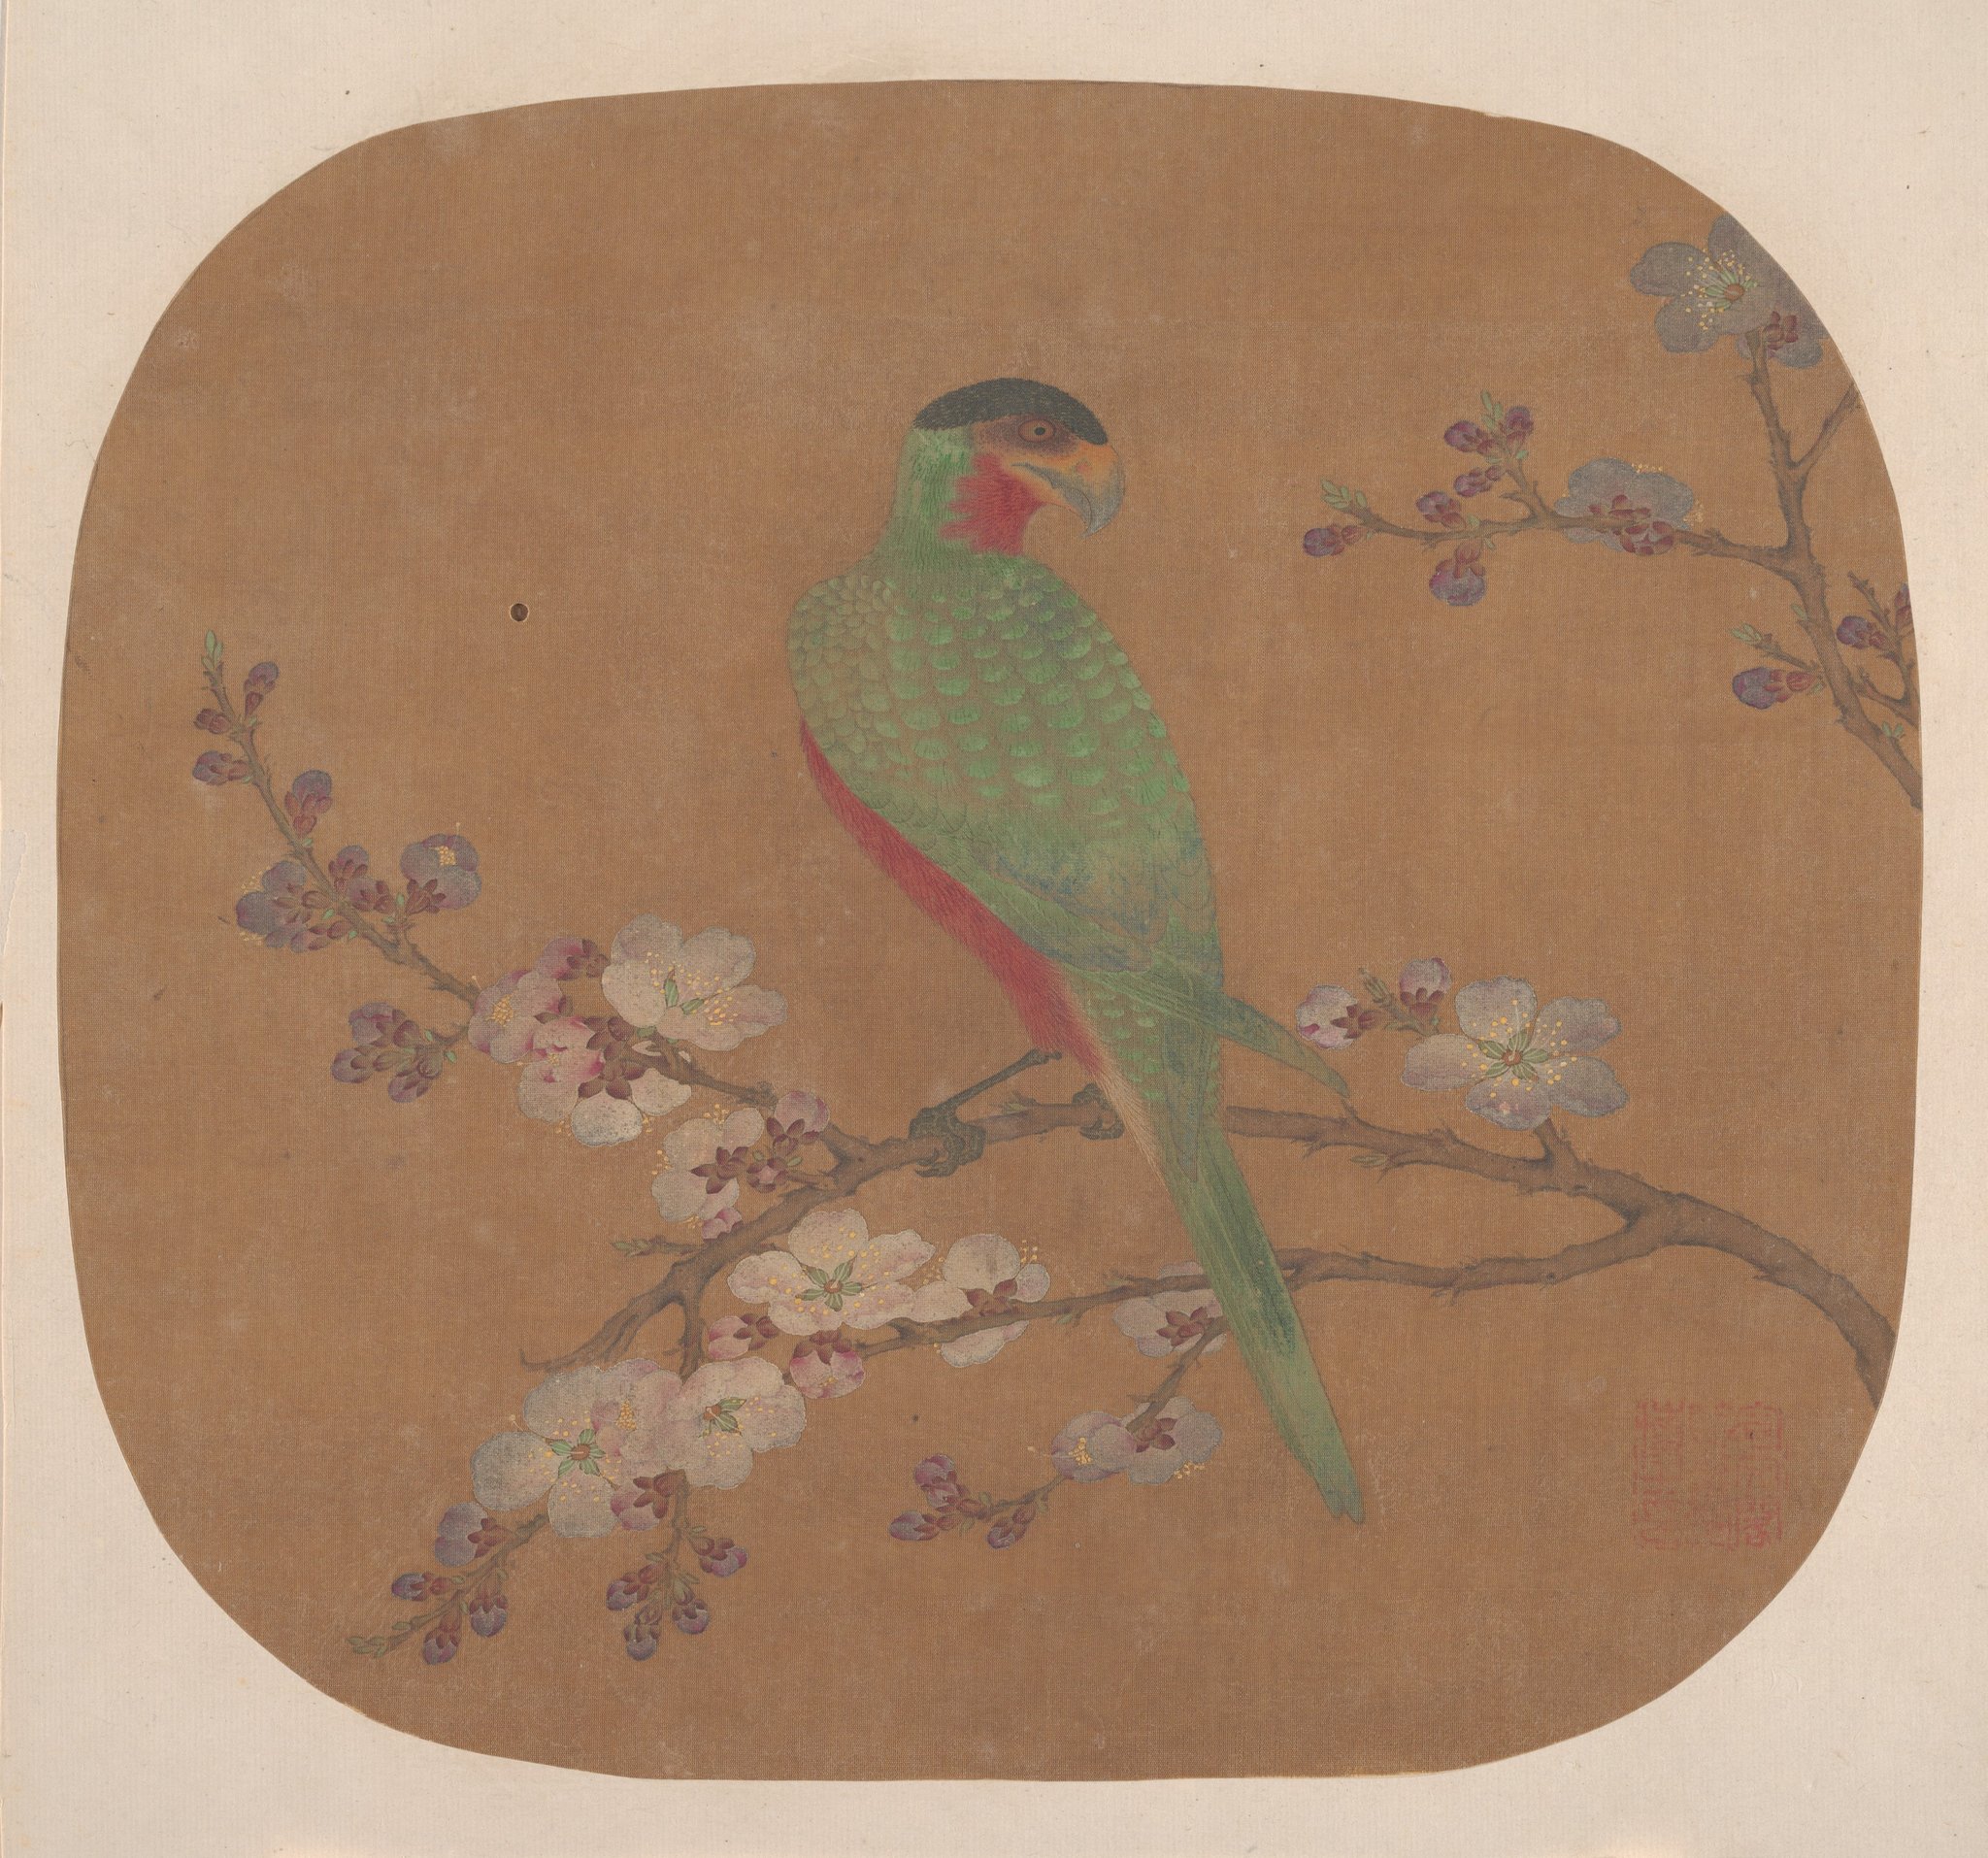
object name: fan mounted a an album leaf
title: Parrot on Branch of Blossoming Tree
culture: chinese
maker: unidentified artist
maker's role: artist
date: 1644-1911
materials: ink, silk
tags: parrots,flowers